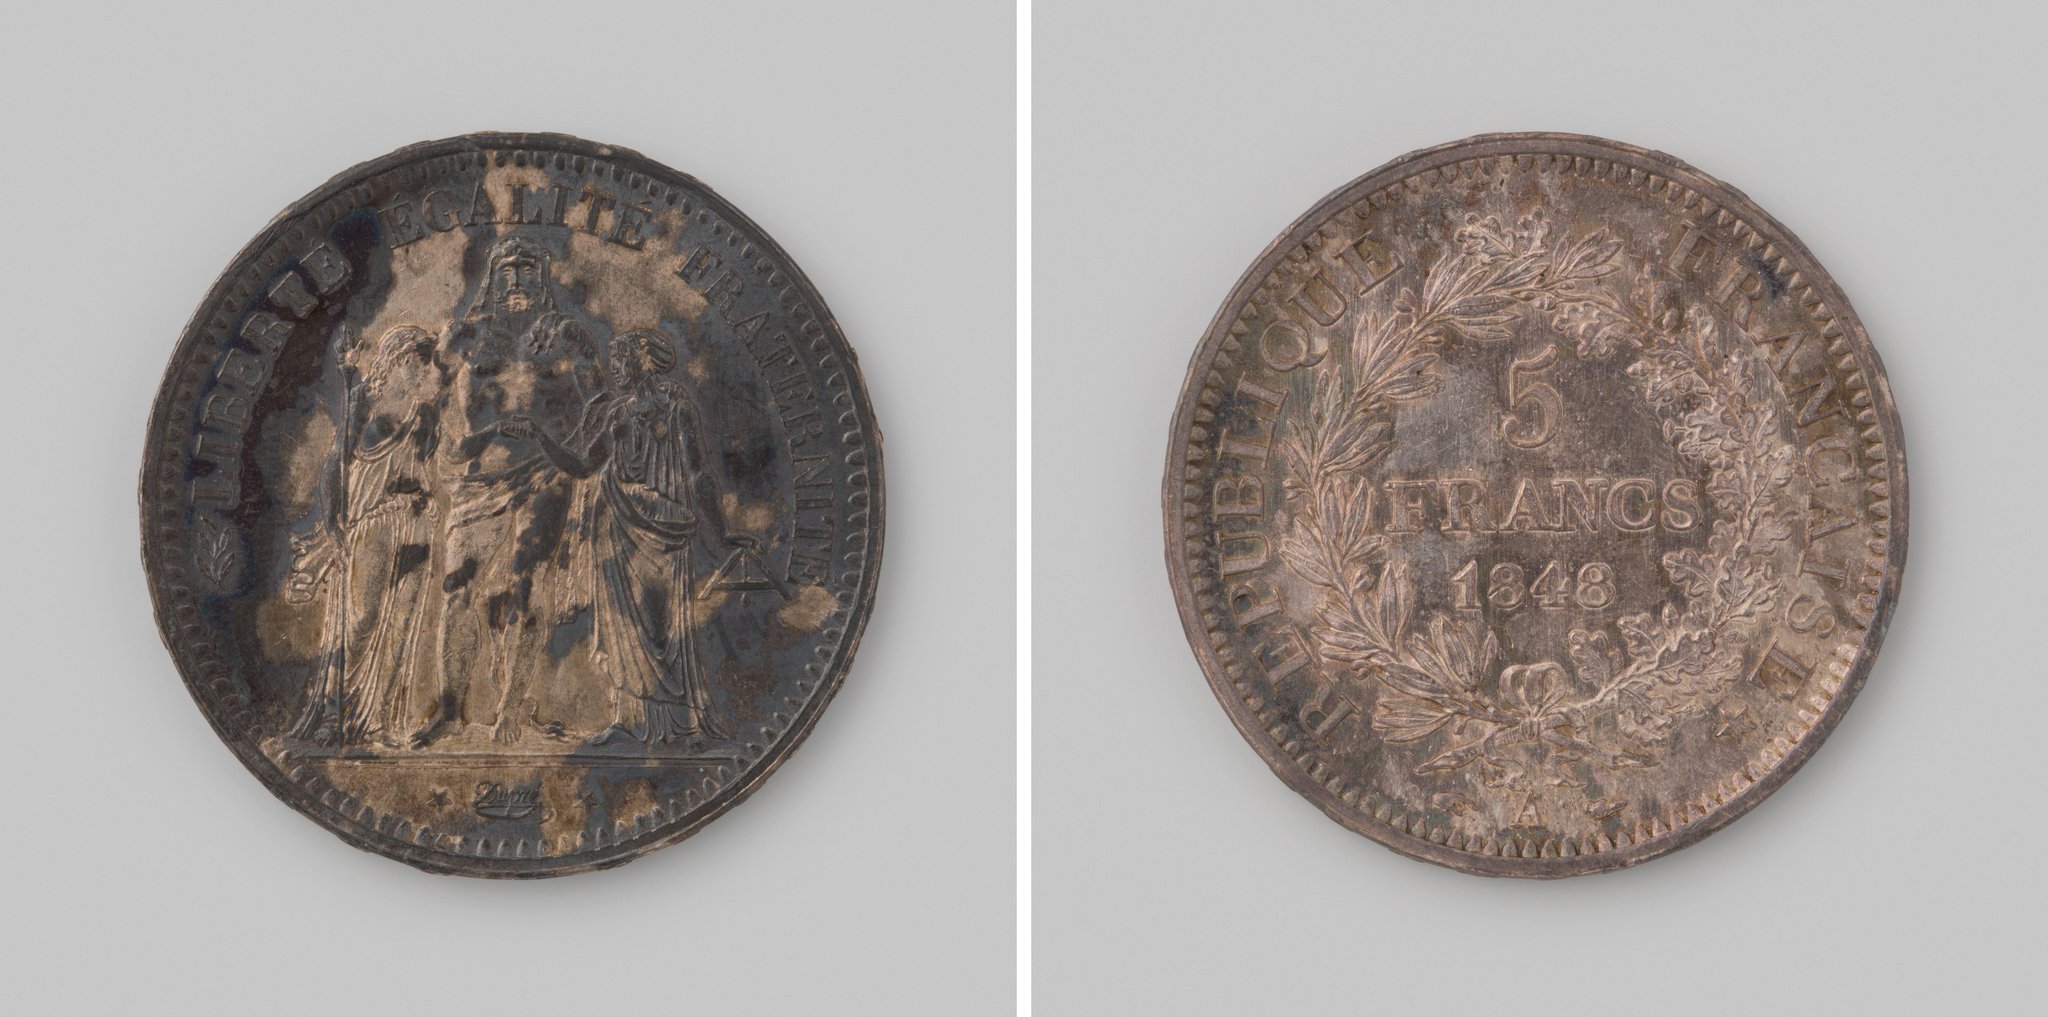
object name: coin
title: 5 francs uit Frankrijk, de Tweede Republiek, 1848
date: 1848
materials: silver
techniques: striking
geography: paris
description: Zilveren munt. Voorzijde: staande man,omringd door twee vrouwen met attributen. Keerzijde: binnen twee samengebonden takken waarde-aanduiding in twee regels, waaronder jaartal. Onderaan de letter A [=Parijs]. Opliggend randschrift.